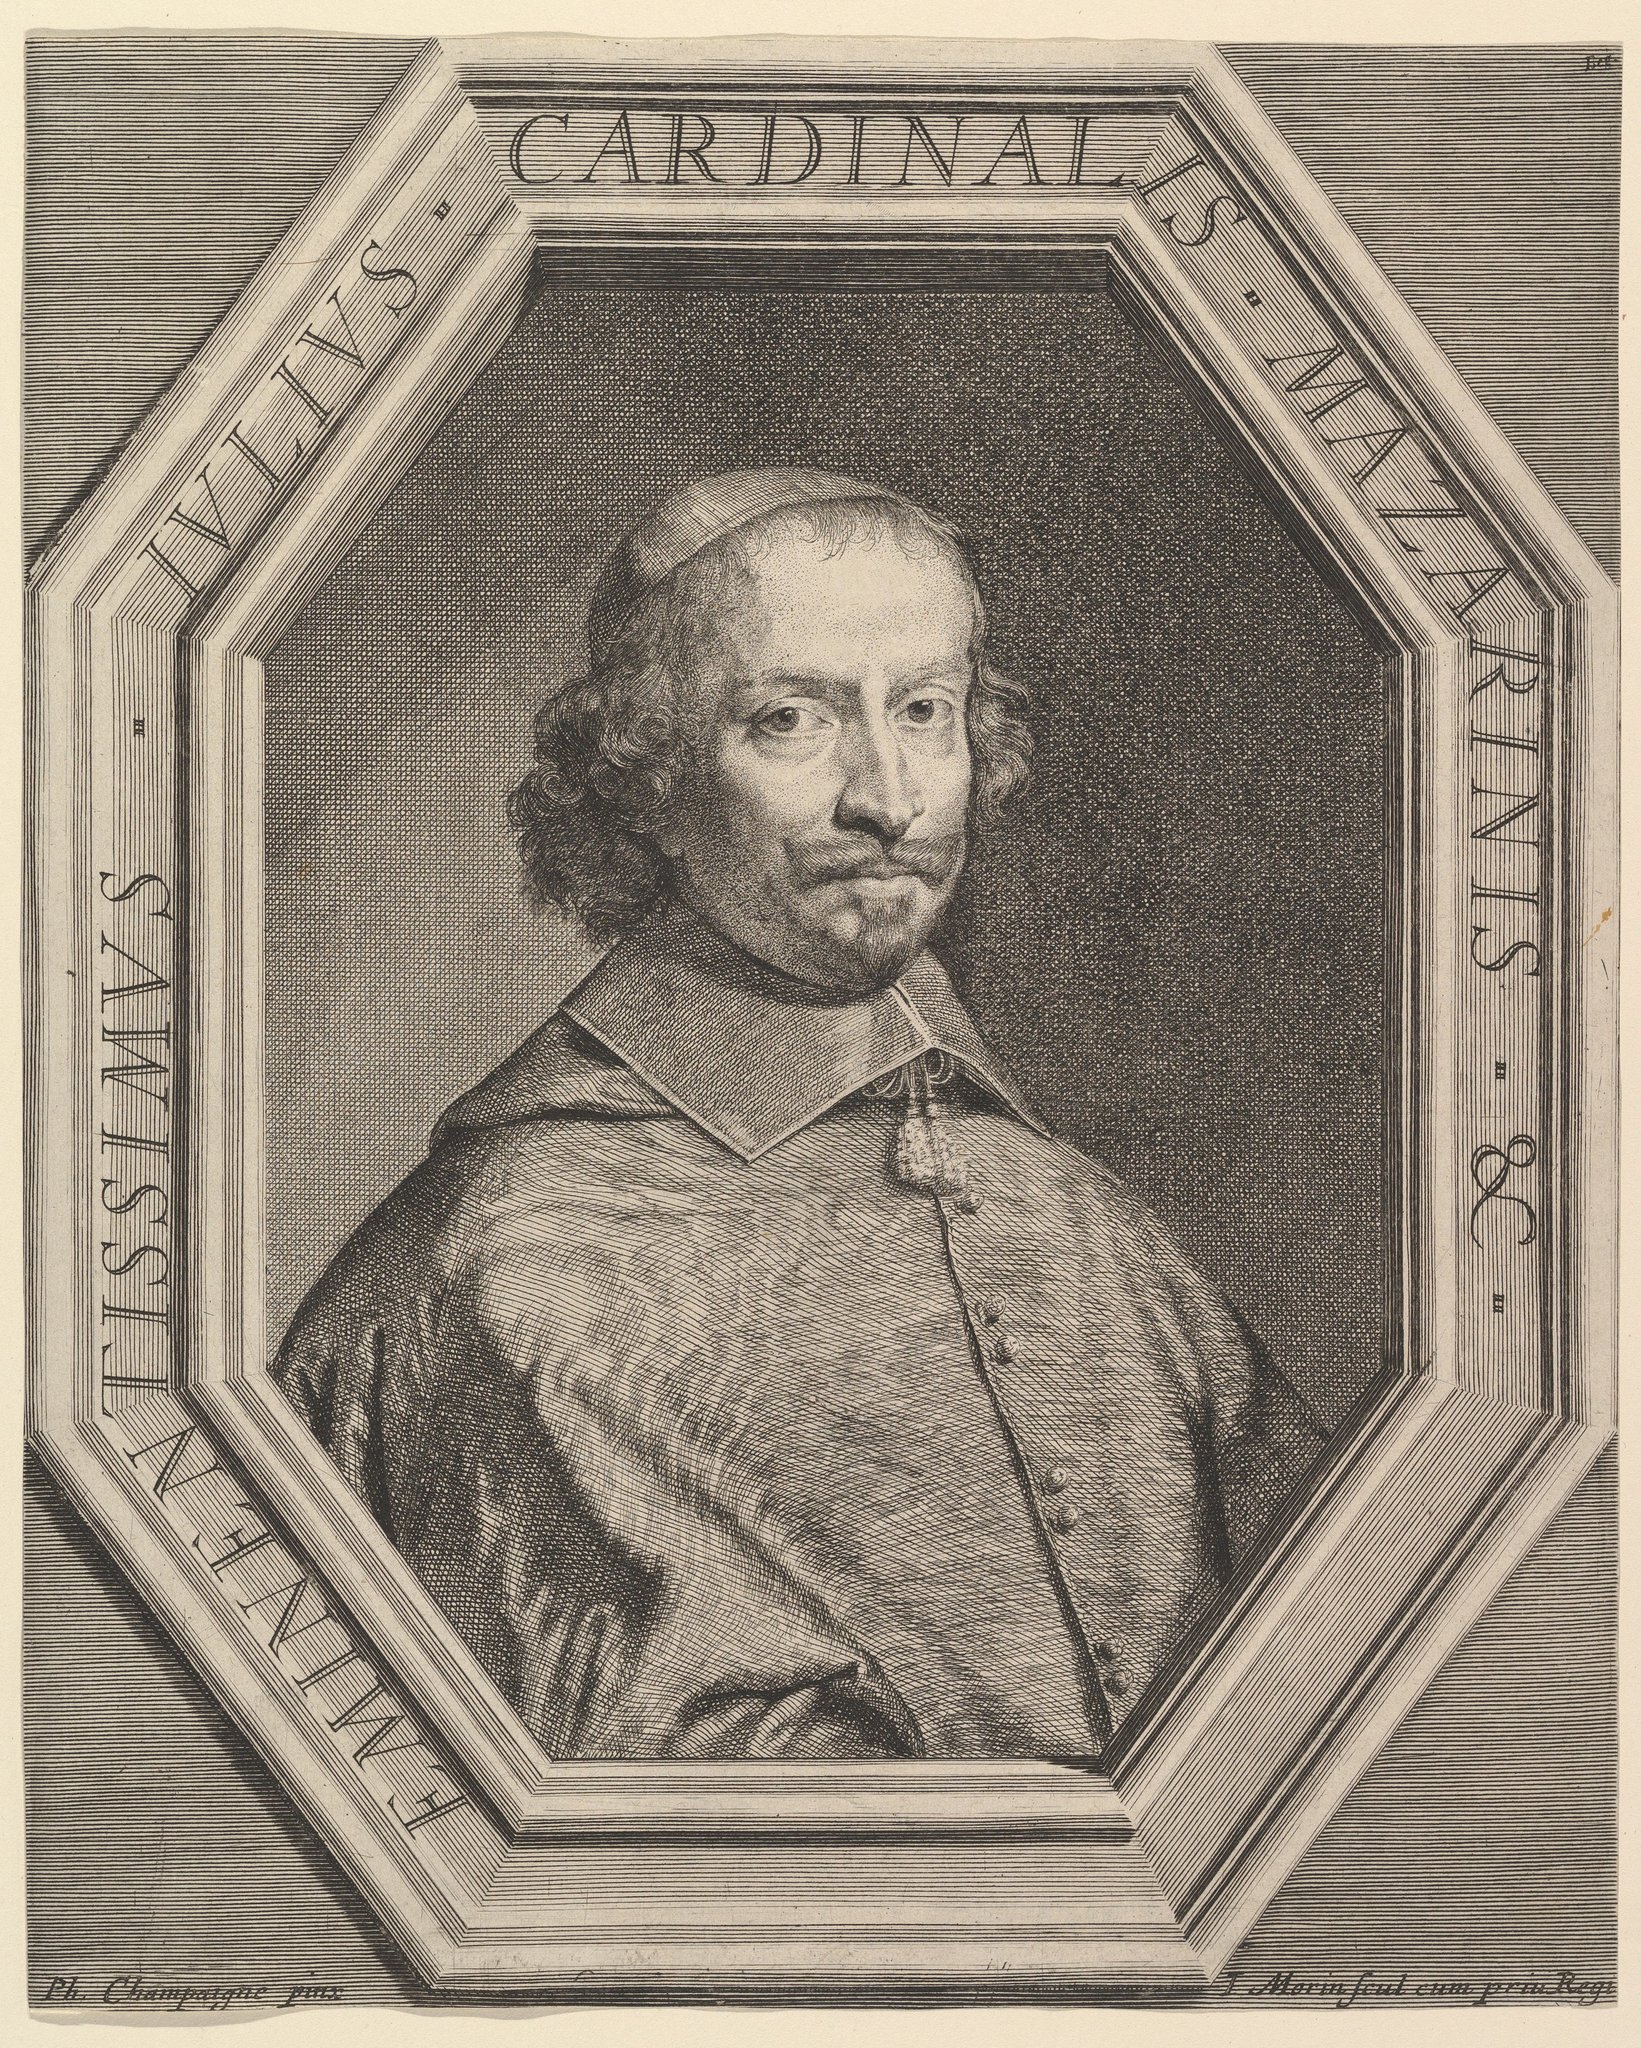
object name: print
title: Cardinal Mazarin, ministre d'Anne d'Autriche et de Louis XIV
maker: jean morin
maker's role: artist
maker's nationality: french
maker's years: 1605-1650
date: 1605-1650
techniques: etching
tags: men,portraits